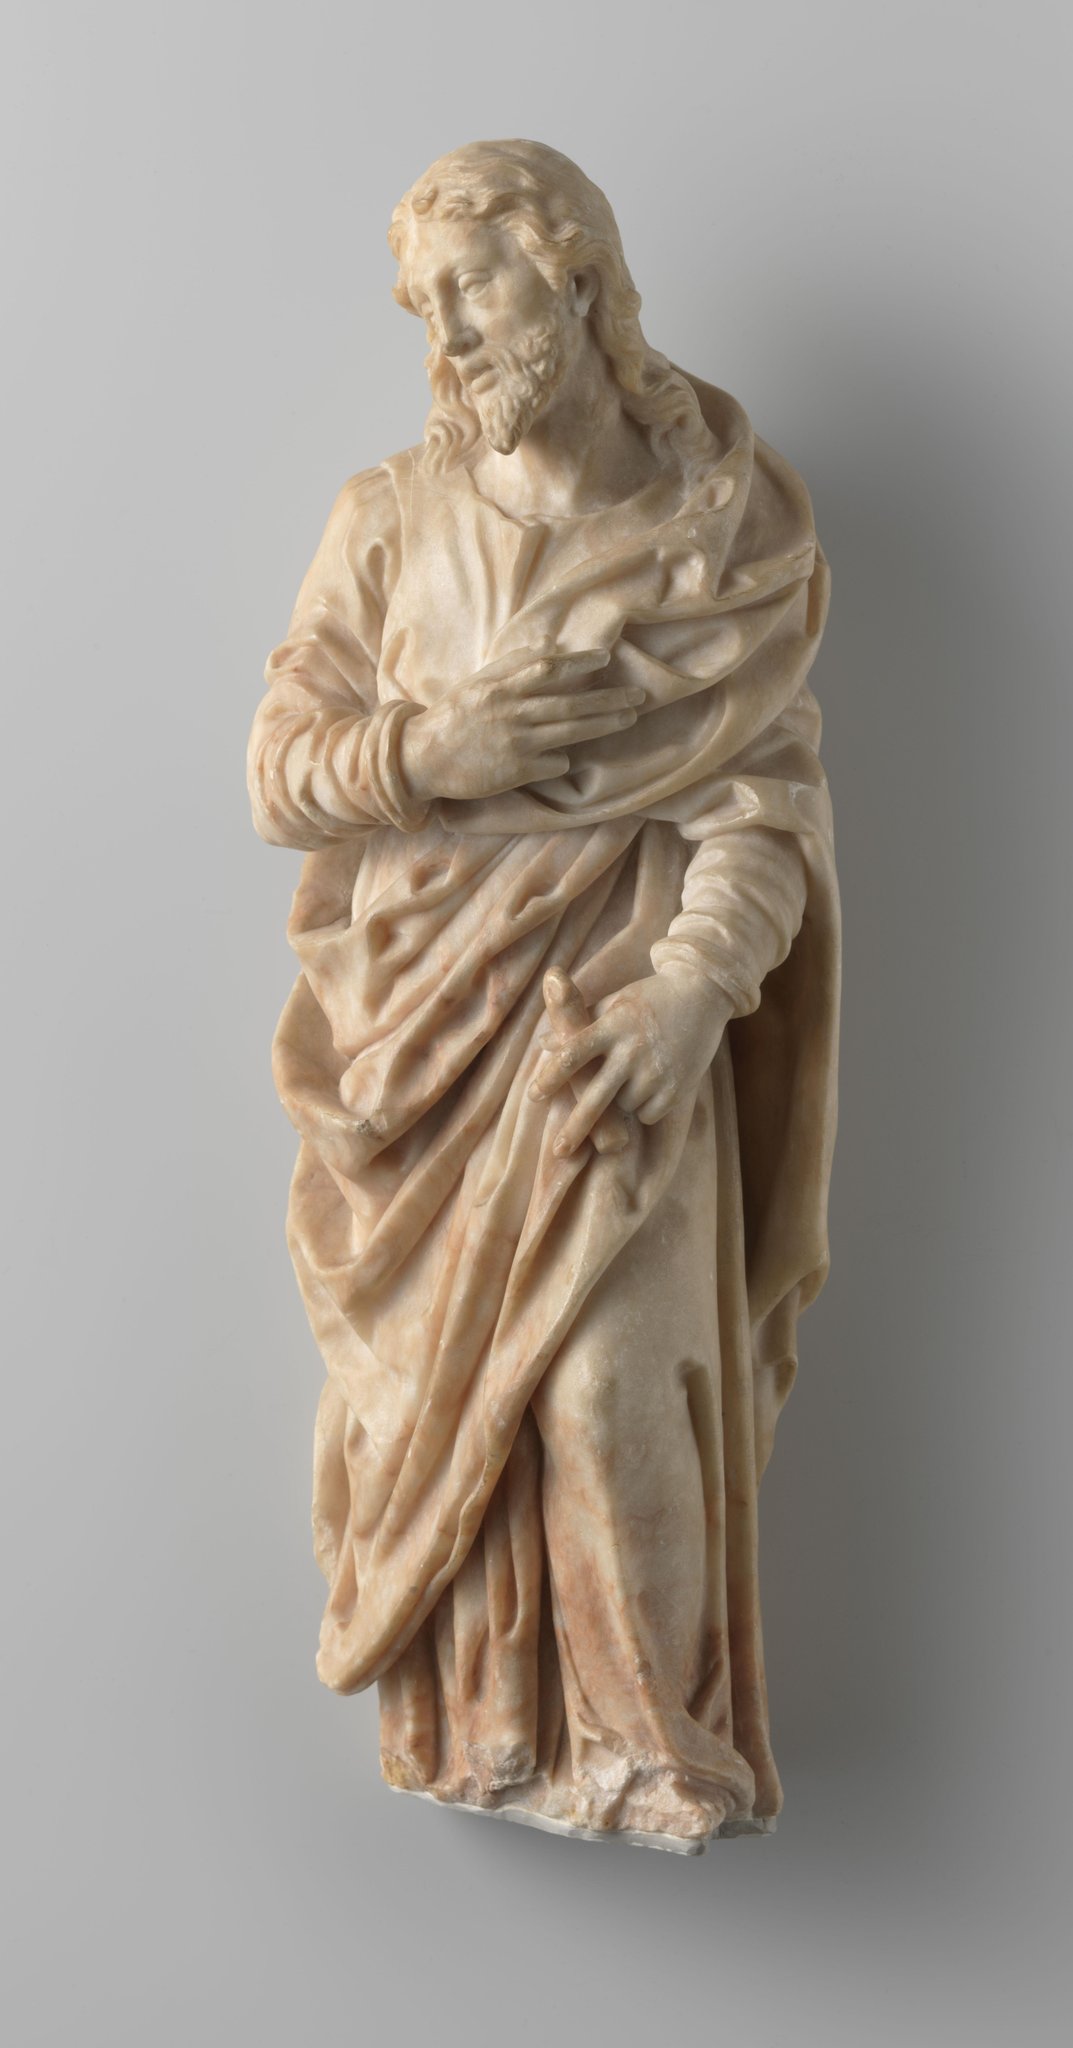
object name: sculpture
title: St Joseph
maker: Anonymous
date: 1600-1625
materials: alabaster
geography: mechelen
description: Saint Joseph (?). Alabaster. Southern Netherlands, c. 1600. Gift of Dr. A.F.E. van Schendel on his retirement as director of the Rijksmuseum in 1975.